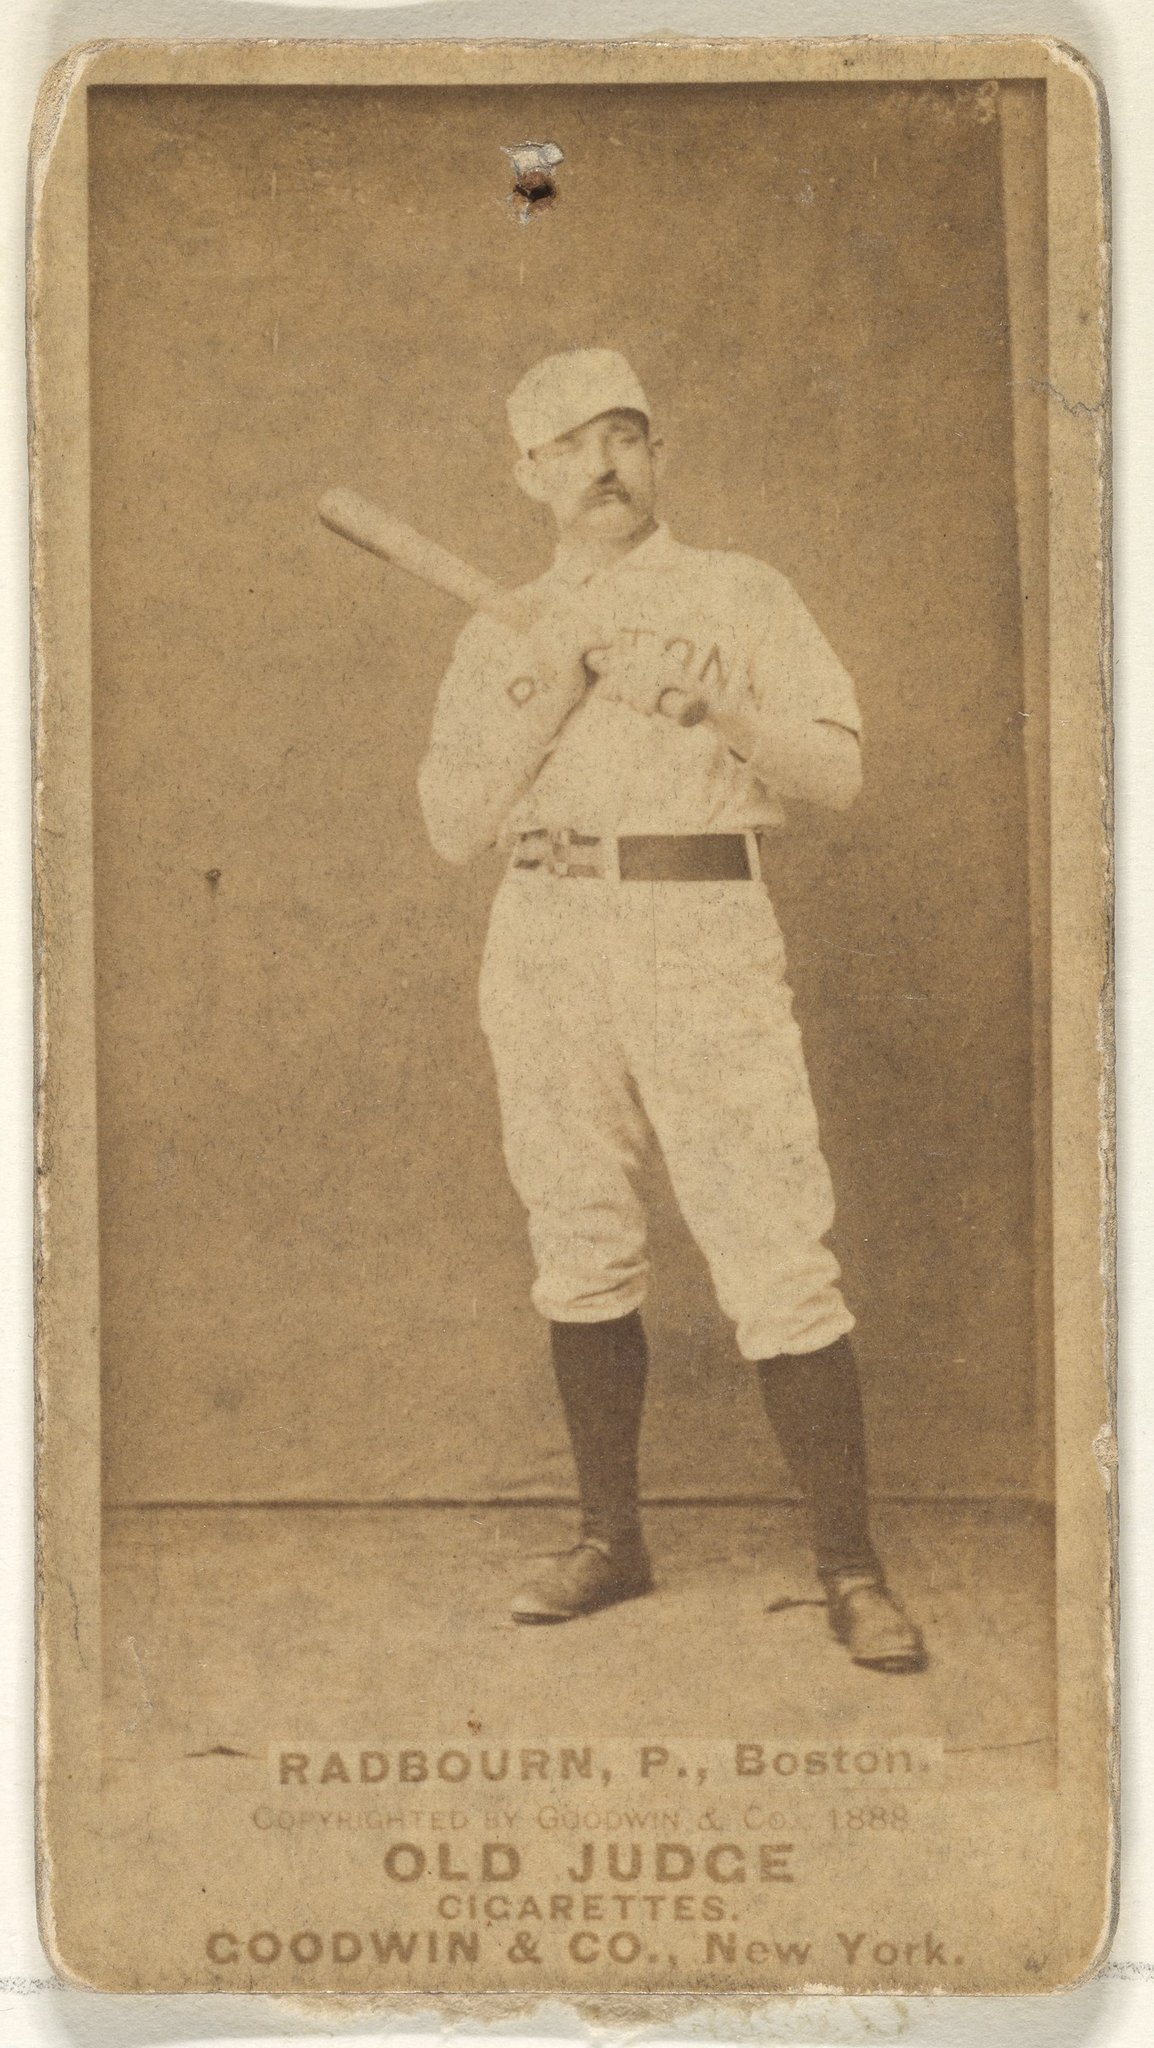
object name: baseball card, photograph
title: Radbourn, Pitcher, Boston, from the Old Judge series (N172) for Old Judge Cigarettes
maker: goodwin & company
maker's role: publisher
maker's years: 1850-1950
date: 1888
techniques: albumen silver print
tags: men,portraits,baseball,athletes